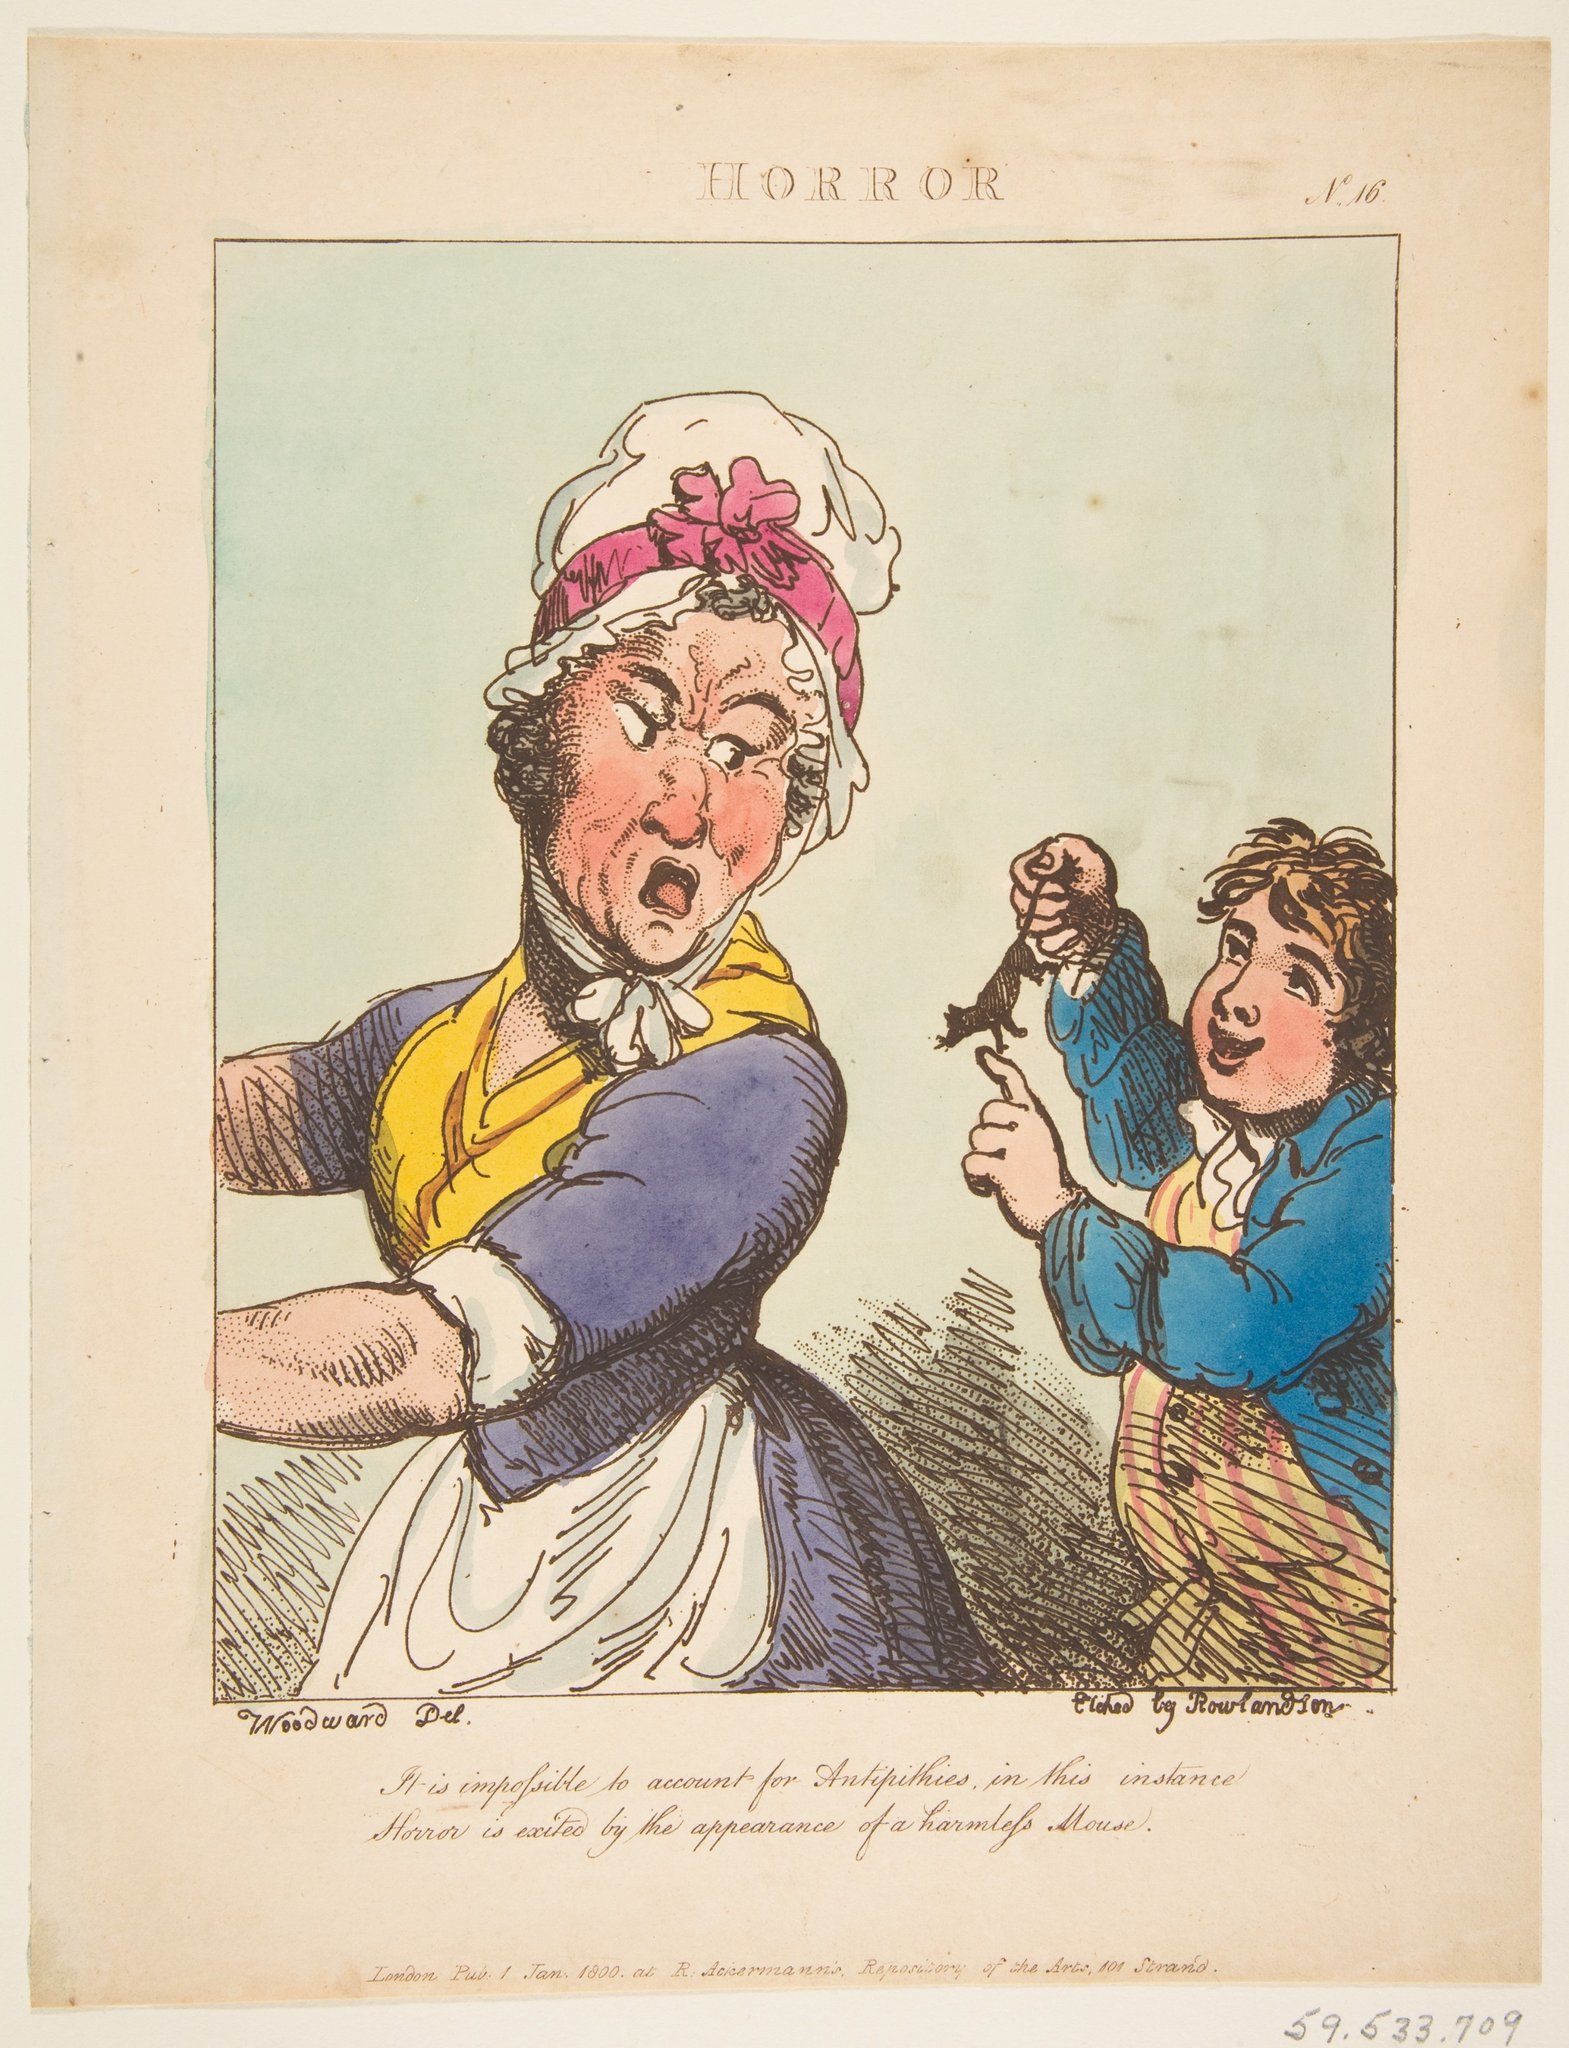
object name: print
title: Horror (Le Brun Travested, or Caricatures of the Passions)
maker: thomas rowlandson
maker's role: artist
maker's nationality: british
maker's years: 1757-1827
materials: ink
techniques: etching, printing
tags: satire,fear,boys,women,mice